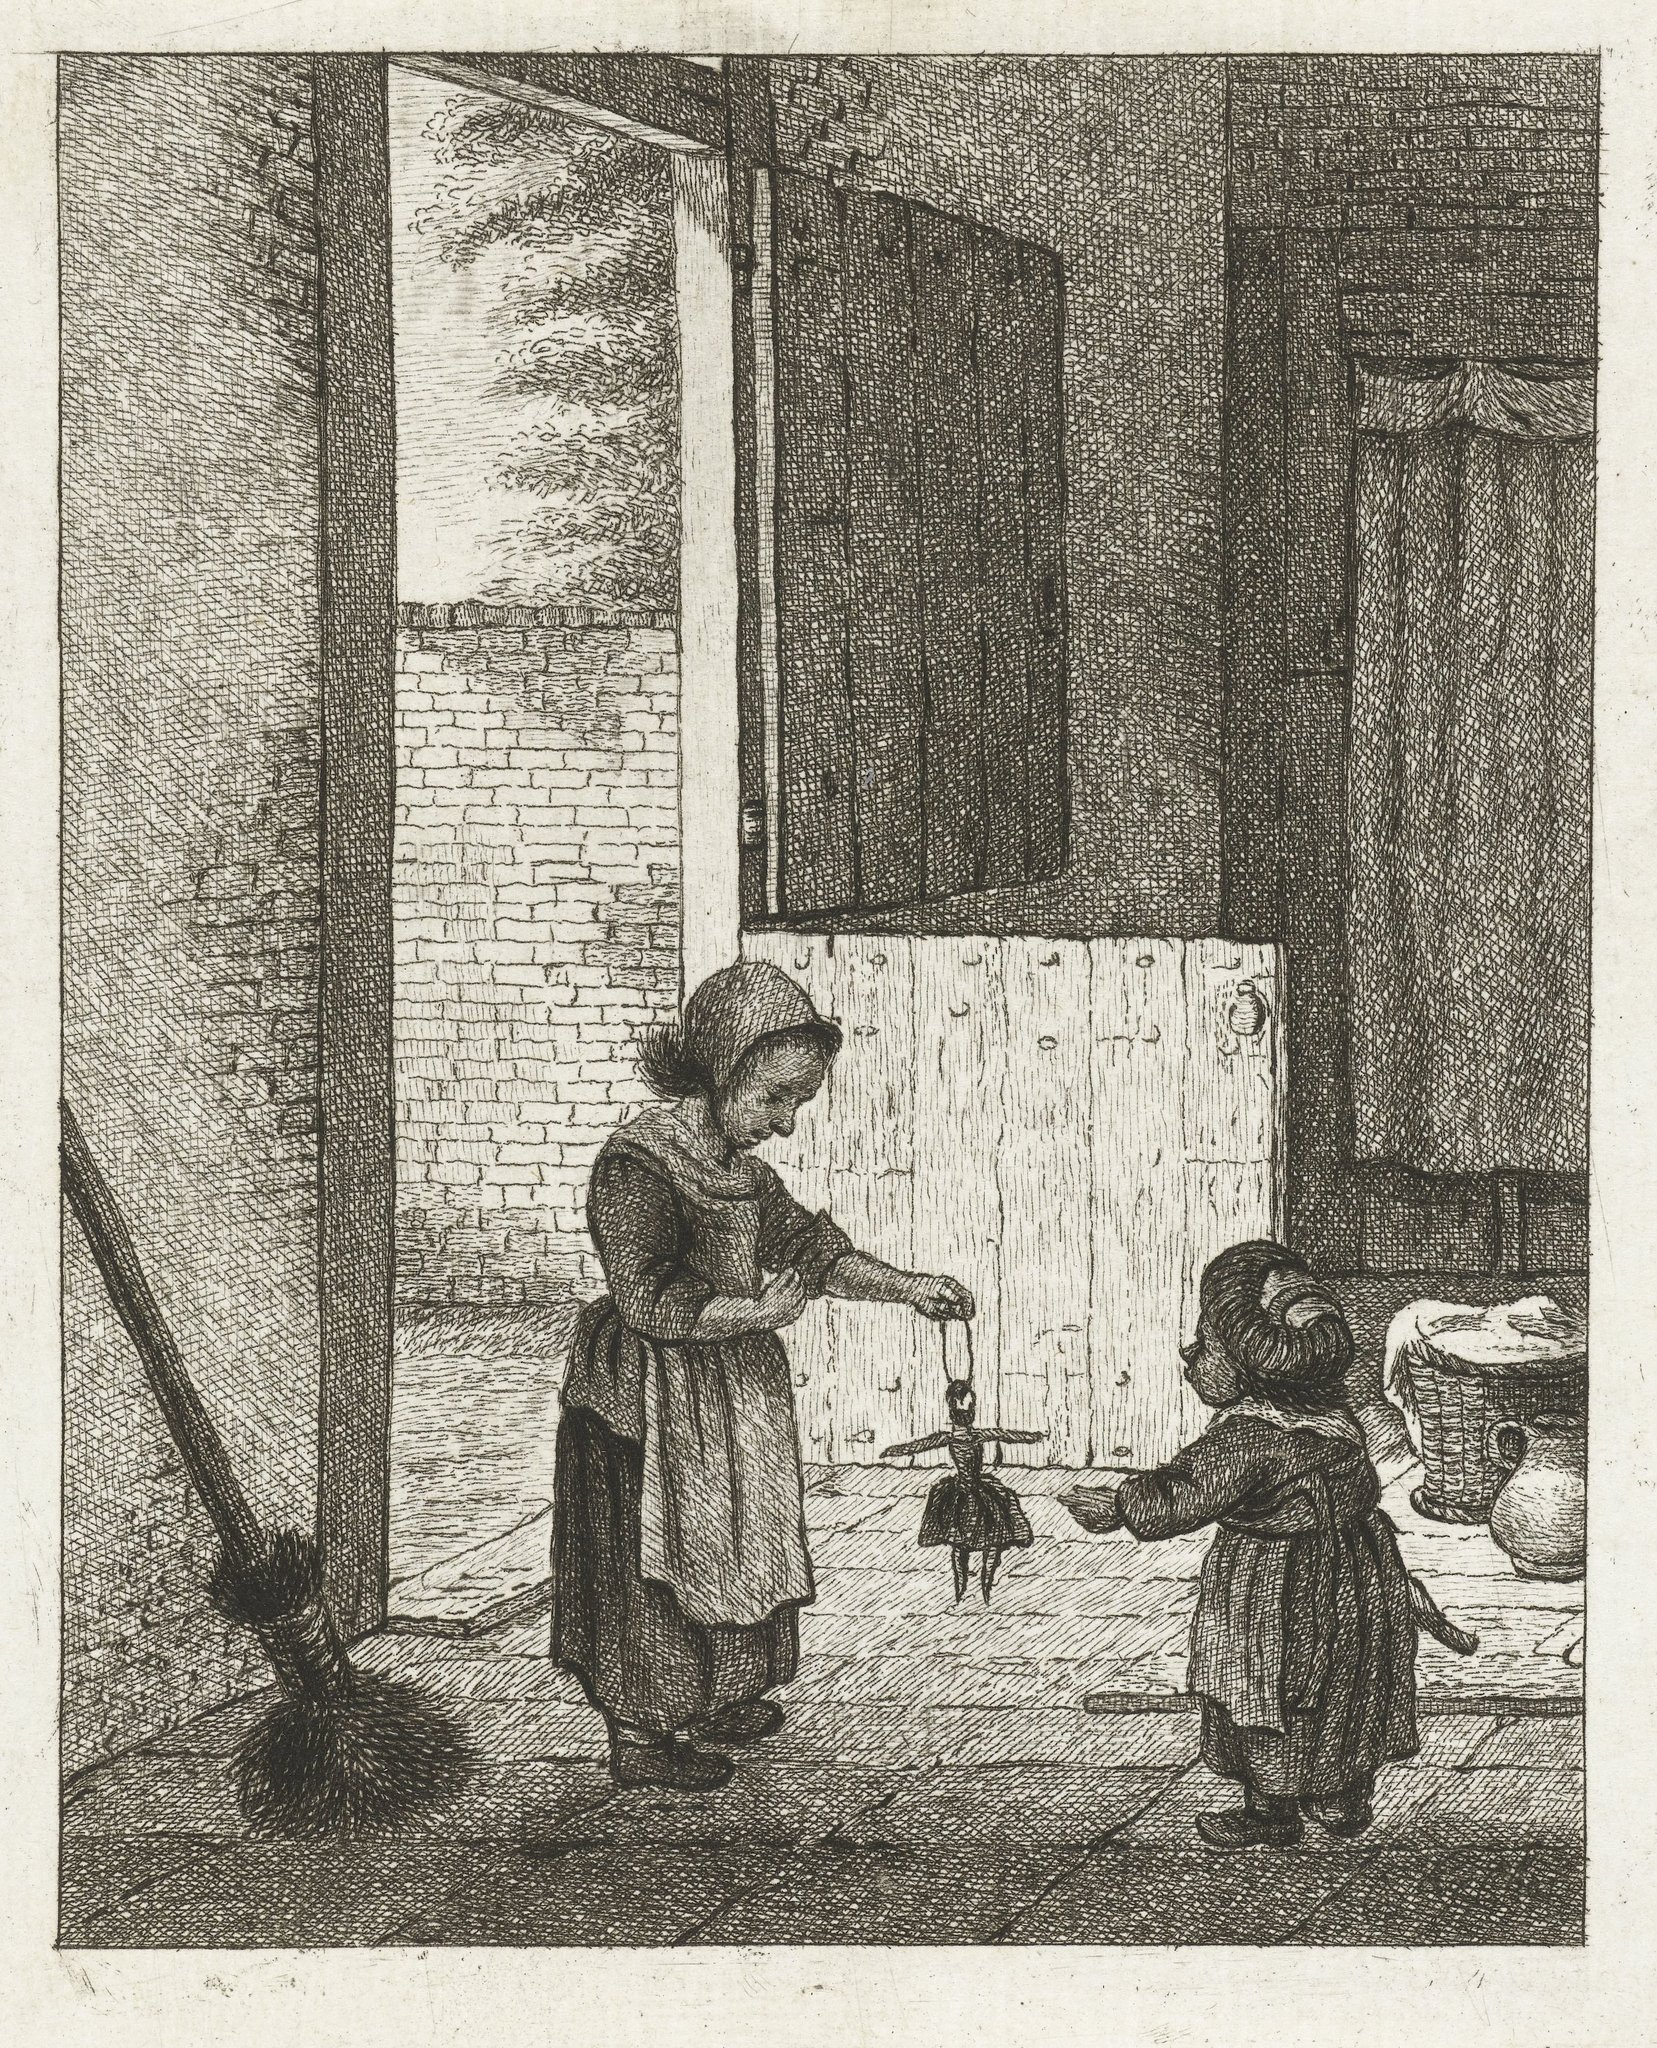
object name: print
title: Twee meisjes spelend met een pop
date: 1779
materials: paper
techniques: etching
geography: leiden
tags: kitchen-interior, (playing with) dolls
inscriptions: collector's mark: Lugt 2233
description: Twee meisjes spelen met een pop in de keuken. Een deur naar de buitenplaats staat open. Op de grond een mand wasgoed en tegen de muur een bezem.